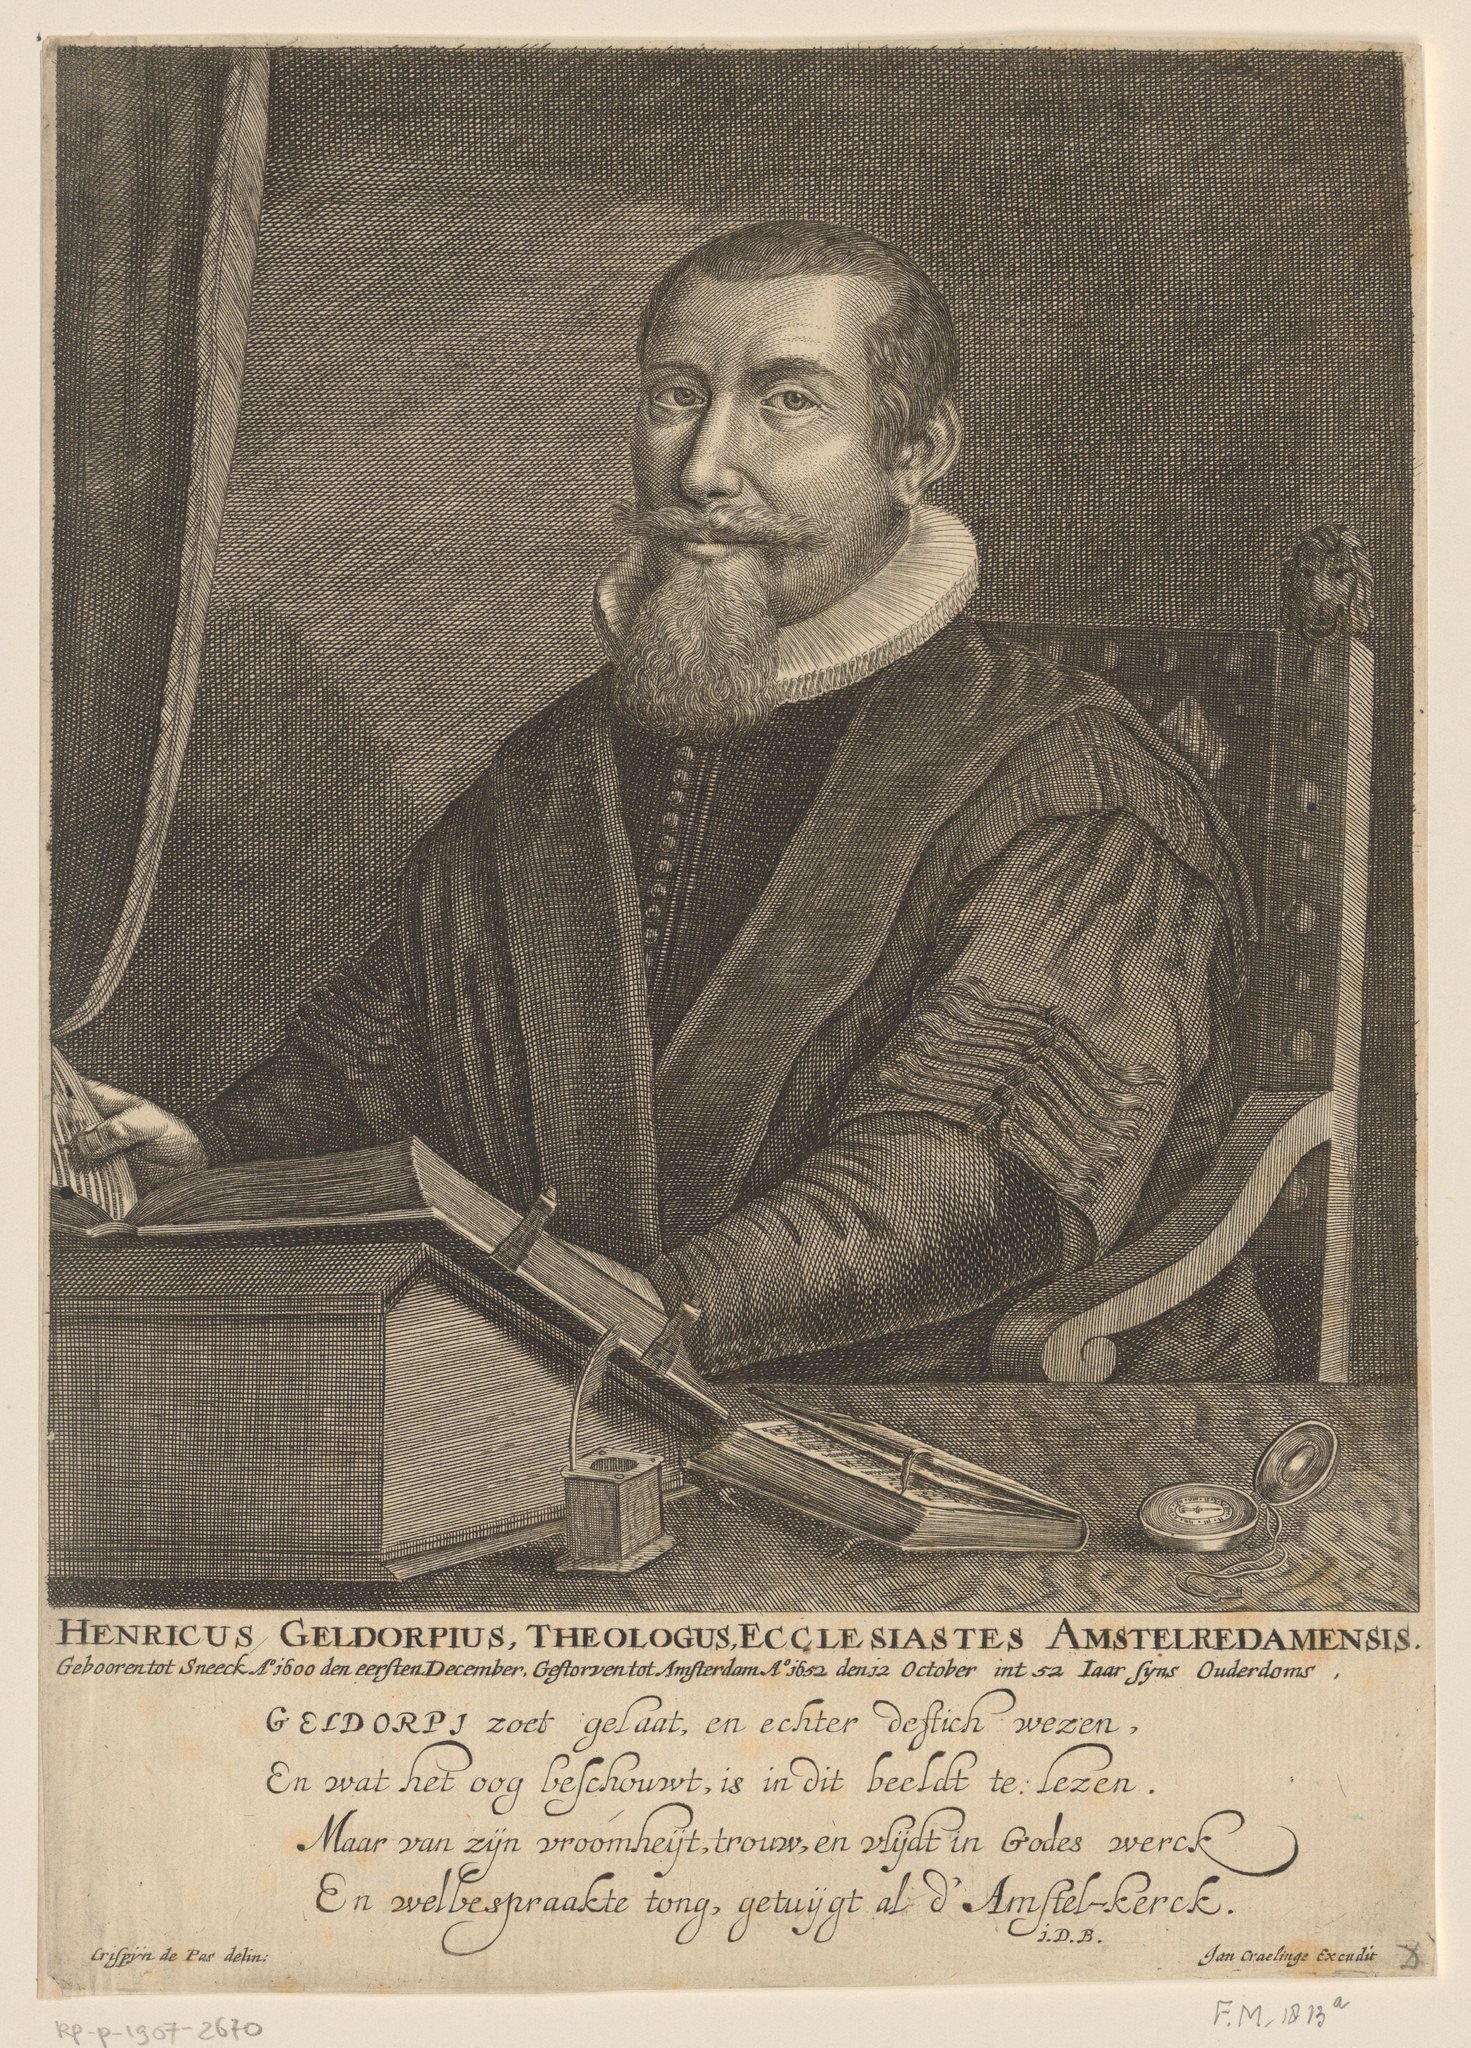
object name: print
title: Portret van Henricus Geldorp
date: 1655-1673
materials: paper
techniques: engraving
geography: amsterdam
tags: amsterdam, theologian, historical persons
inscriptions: collector's mark: Lugt 2228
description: Tekst in het Nederlands in de ondermarge.